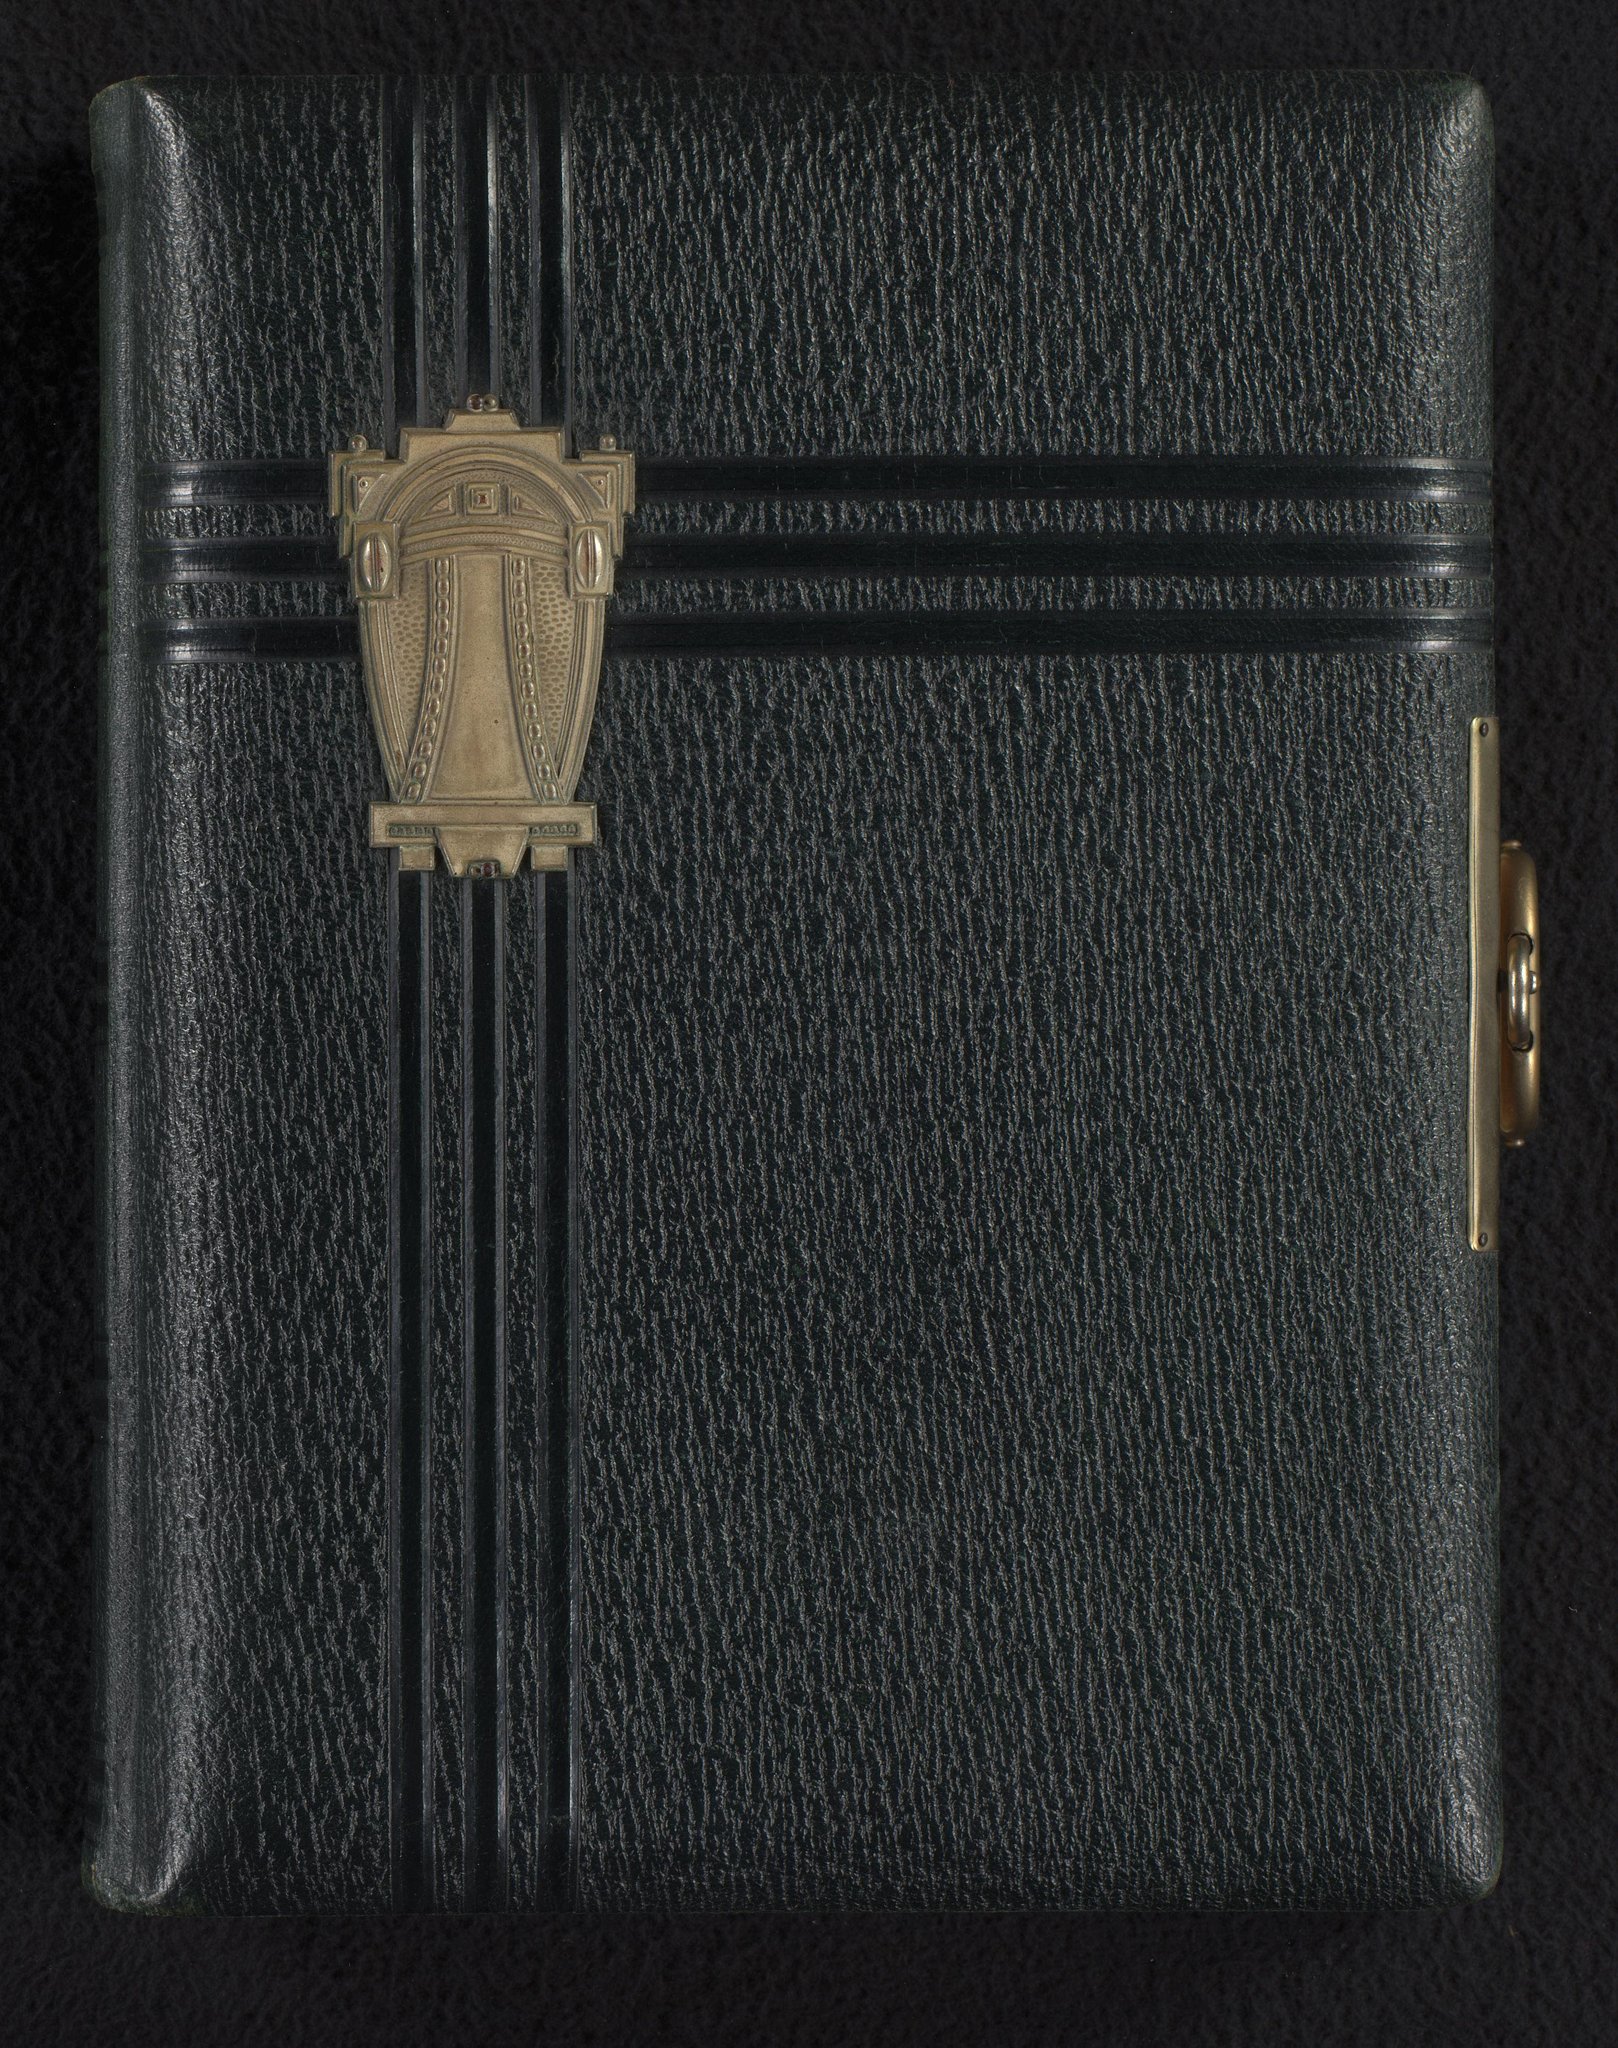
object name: slip in album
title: Fotoalbum met 64 foto's, Nederlands en Engels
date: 1860-1910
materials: cardboard, leather, metal, paper, photographic support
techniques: albumen print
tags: anonymous historical persons portrayed in a group, in a group-portrait - bb - woman, historical persons - bb - woman, boy (child between toddler and youth), historical persons, girl (child between toddler and youth), anonymous historical persons portrayed in a group, in a group-portrait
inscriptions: collector's mark: ‘Dienst Verspreide Rijkscollekties/ Inv.nr: A818’, number: ‘8277/4.50’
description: Fotoalbum met 64 foto's op 14 bladen. Het album carte-de-visites en kabinetfoto's met portretten en groepsportretten. Van enkele personen is de naam bekend hoewel het merendeel onbekend is. De portretten zijn vervaardigd in Nederland en Engeland, onder andere door Adolphe Zimmermans, Carel Eduard Westerborg en Bayley's Studios.